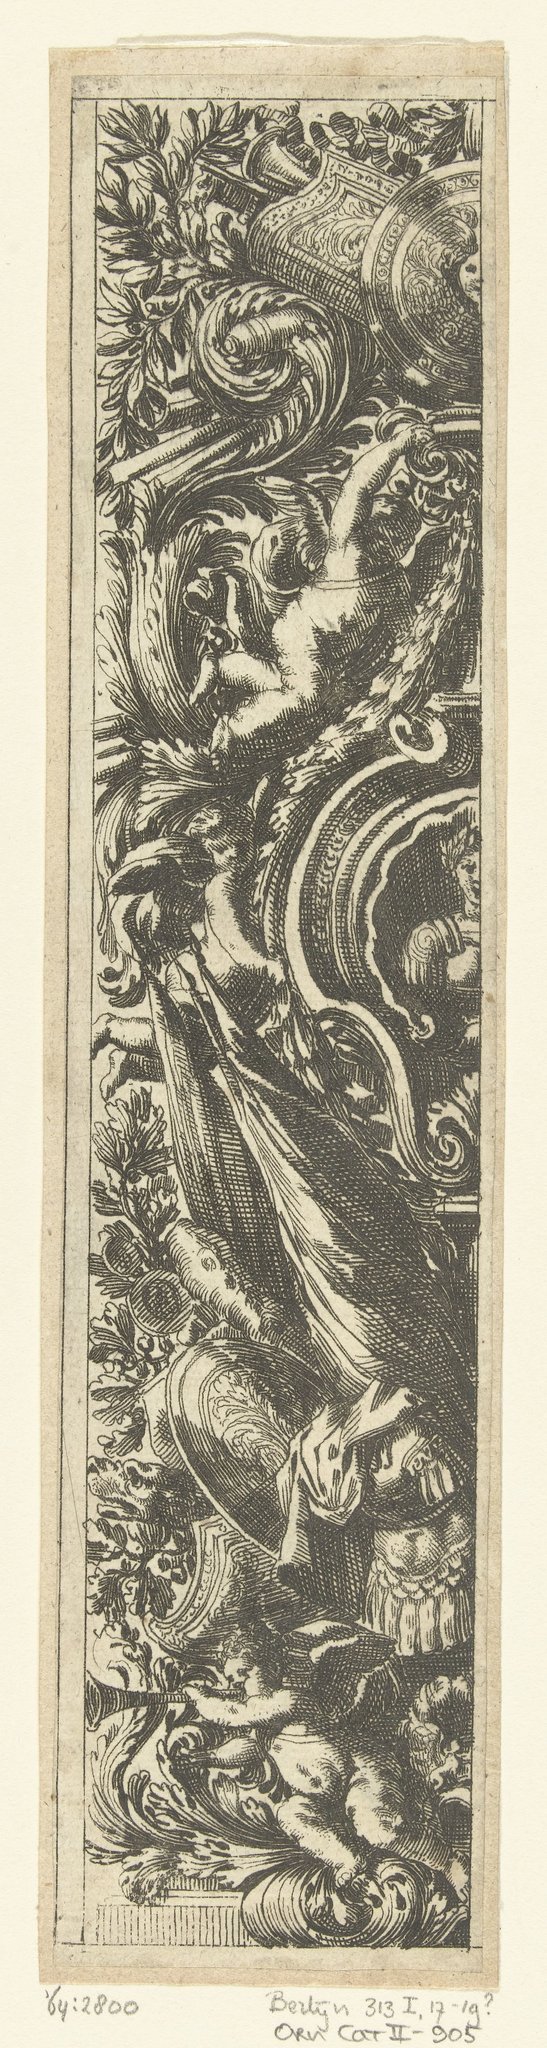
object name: print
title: Grotesques et moresques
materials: paper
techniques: etching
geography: france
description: In het midden staat een keizersbuste voor een schelp, boven- en onderaan zijn wapentrofeeën afgebeeld. Linkerpaneel van blad 6, vormde oorspronkelijk samen met twee andere panelen (RP-P-1964-2807 en RP-P-1964-2808) één geheel. Blad uit tweede editie.